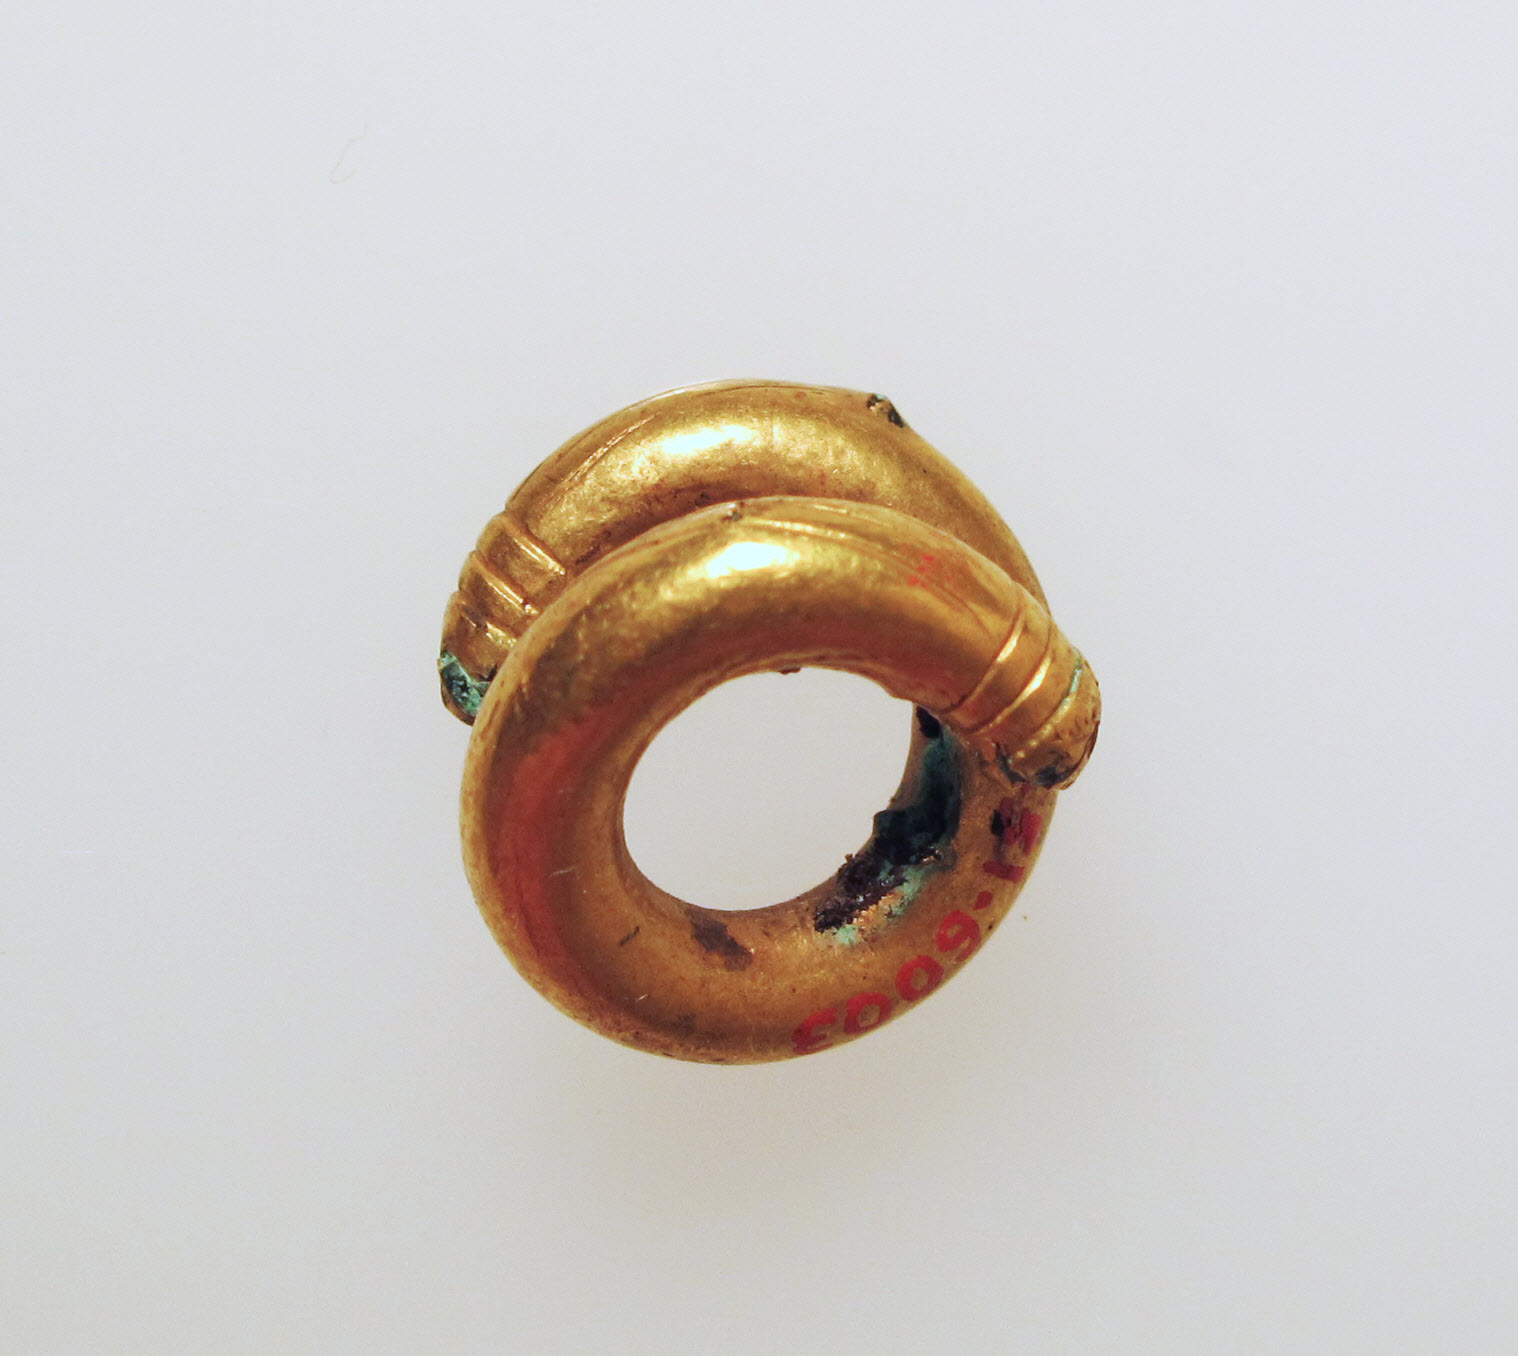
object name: earring or spiral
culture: cypriot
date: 500-401 BCE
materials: bronze, gold